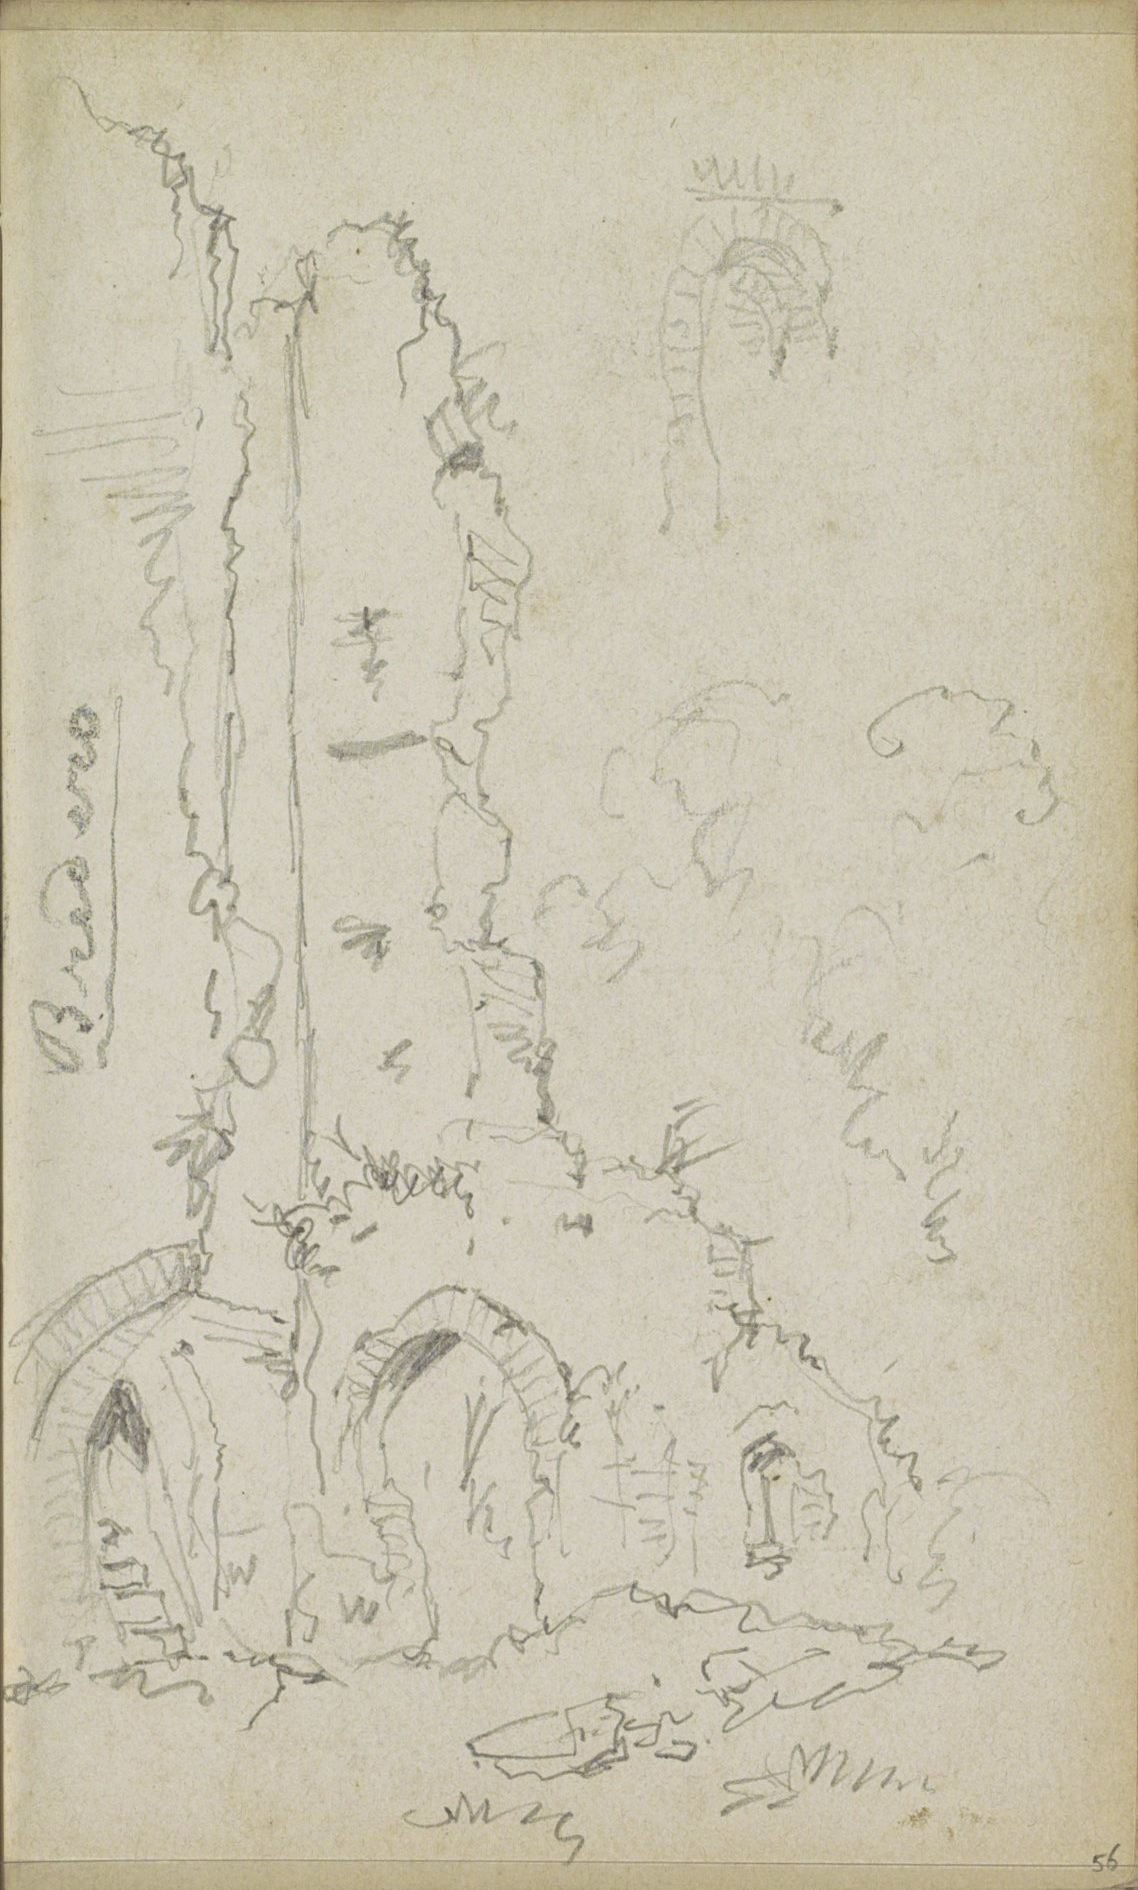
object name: sketchbook leaf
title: Gezicht op de ruïne van Kasteel Brederode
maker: adrianus eversen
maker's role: draughtsman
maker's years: 1818-1897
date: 1828-1897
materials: paper, pencil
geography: santpoort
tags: ruin of a dwelling, house, castle, etc.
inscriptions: annotation: ‘Bredero’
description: Gezicht op de ruïne van Kasteel Brederode. Rechtsboven een boog. Blad 56 recto uit een schetsboek met 69 bladen vervaardigd in de omgeving van Delft, Rotterdam, Oudewater en Harlingen.